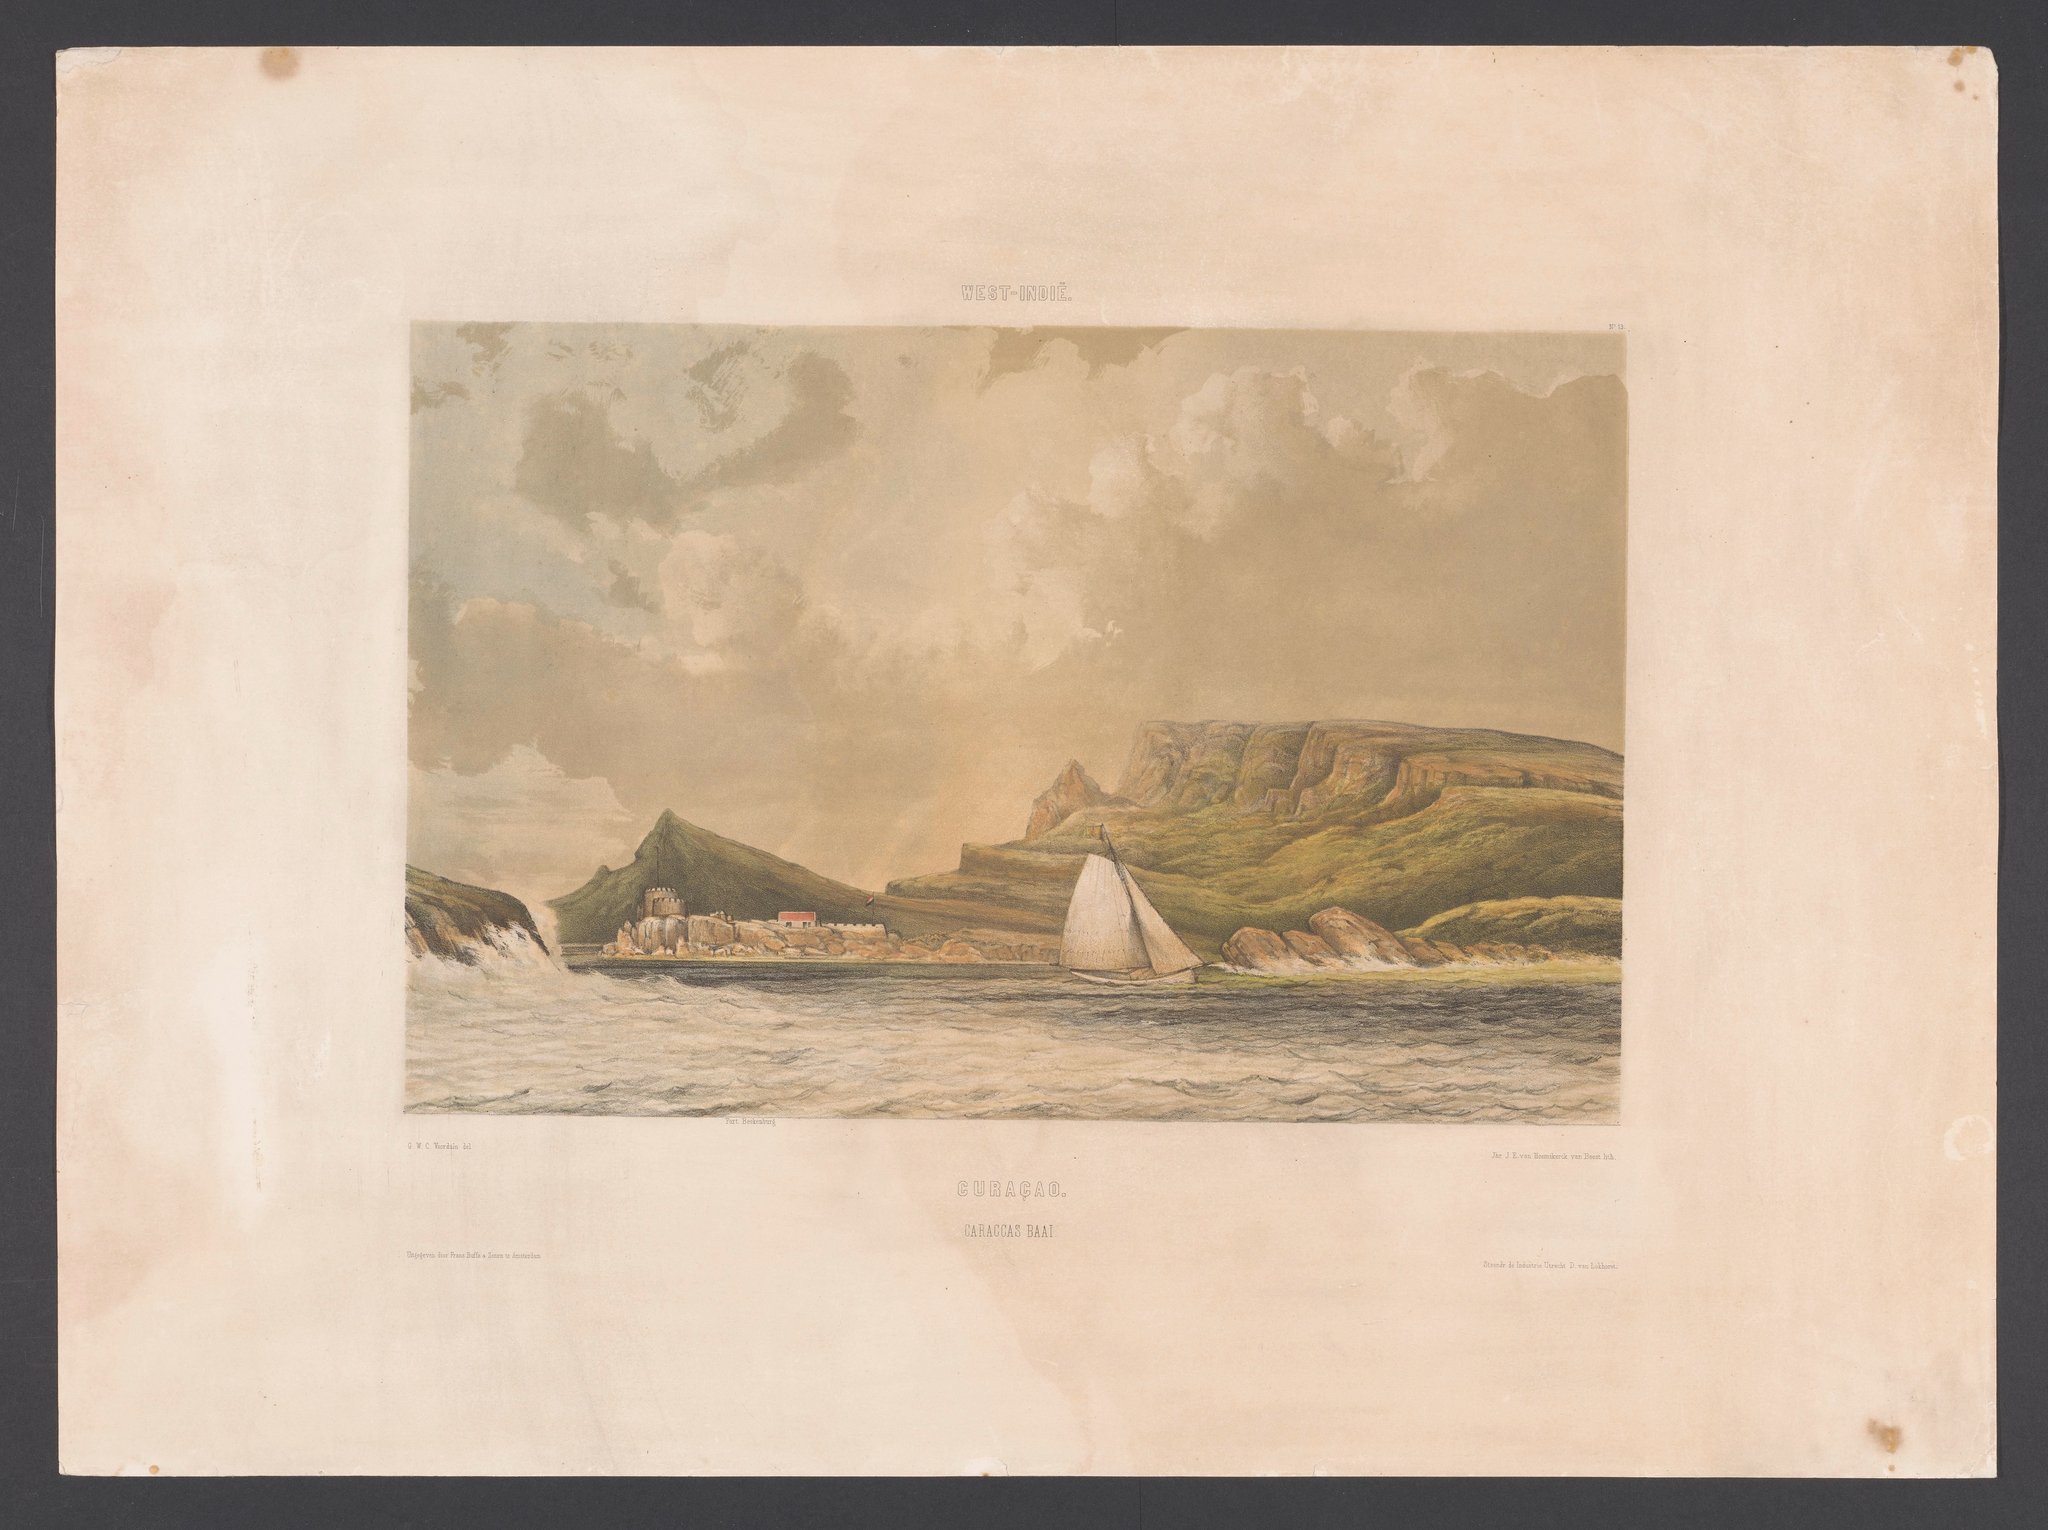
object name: print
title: Curaçao. Caraccas Baai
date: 1860-1862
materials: paper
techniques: lithograph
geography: amsterdam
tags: gulf, bay, fortress, sailing-ship, sailing-boat, landscapes with waters, waterscapes, seascapes (in the temperate zone)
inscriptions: collector's mark: Lugt 2760, collector's mark: Lugt 2228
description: Gezicht op Caracasbaai bij Willemstad. Op de plaat staat verder aangegeven: Fort Beekenburg. Prent maakt deel uit van een omslag met zeventien bladen.